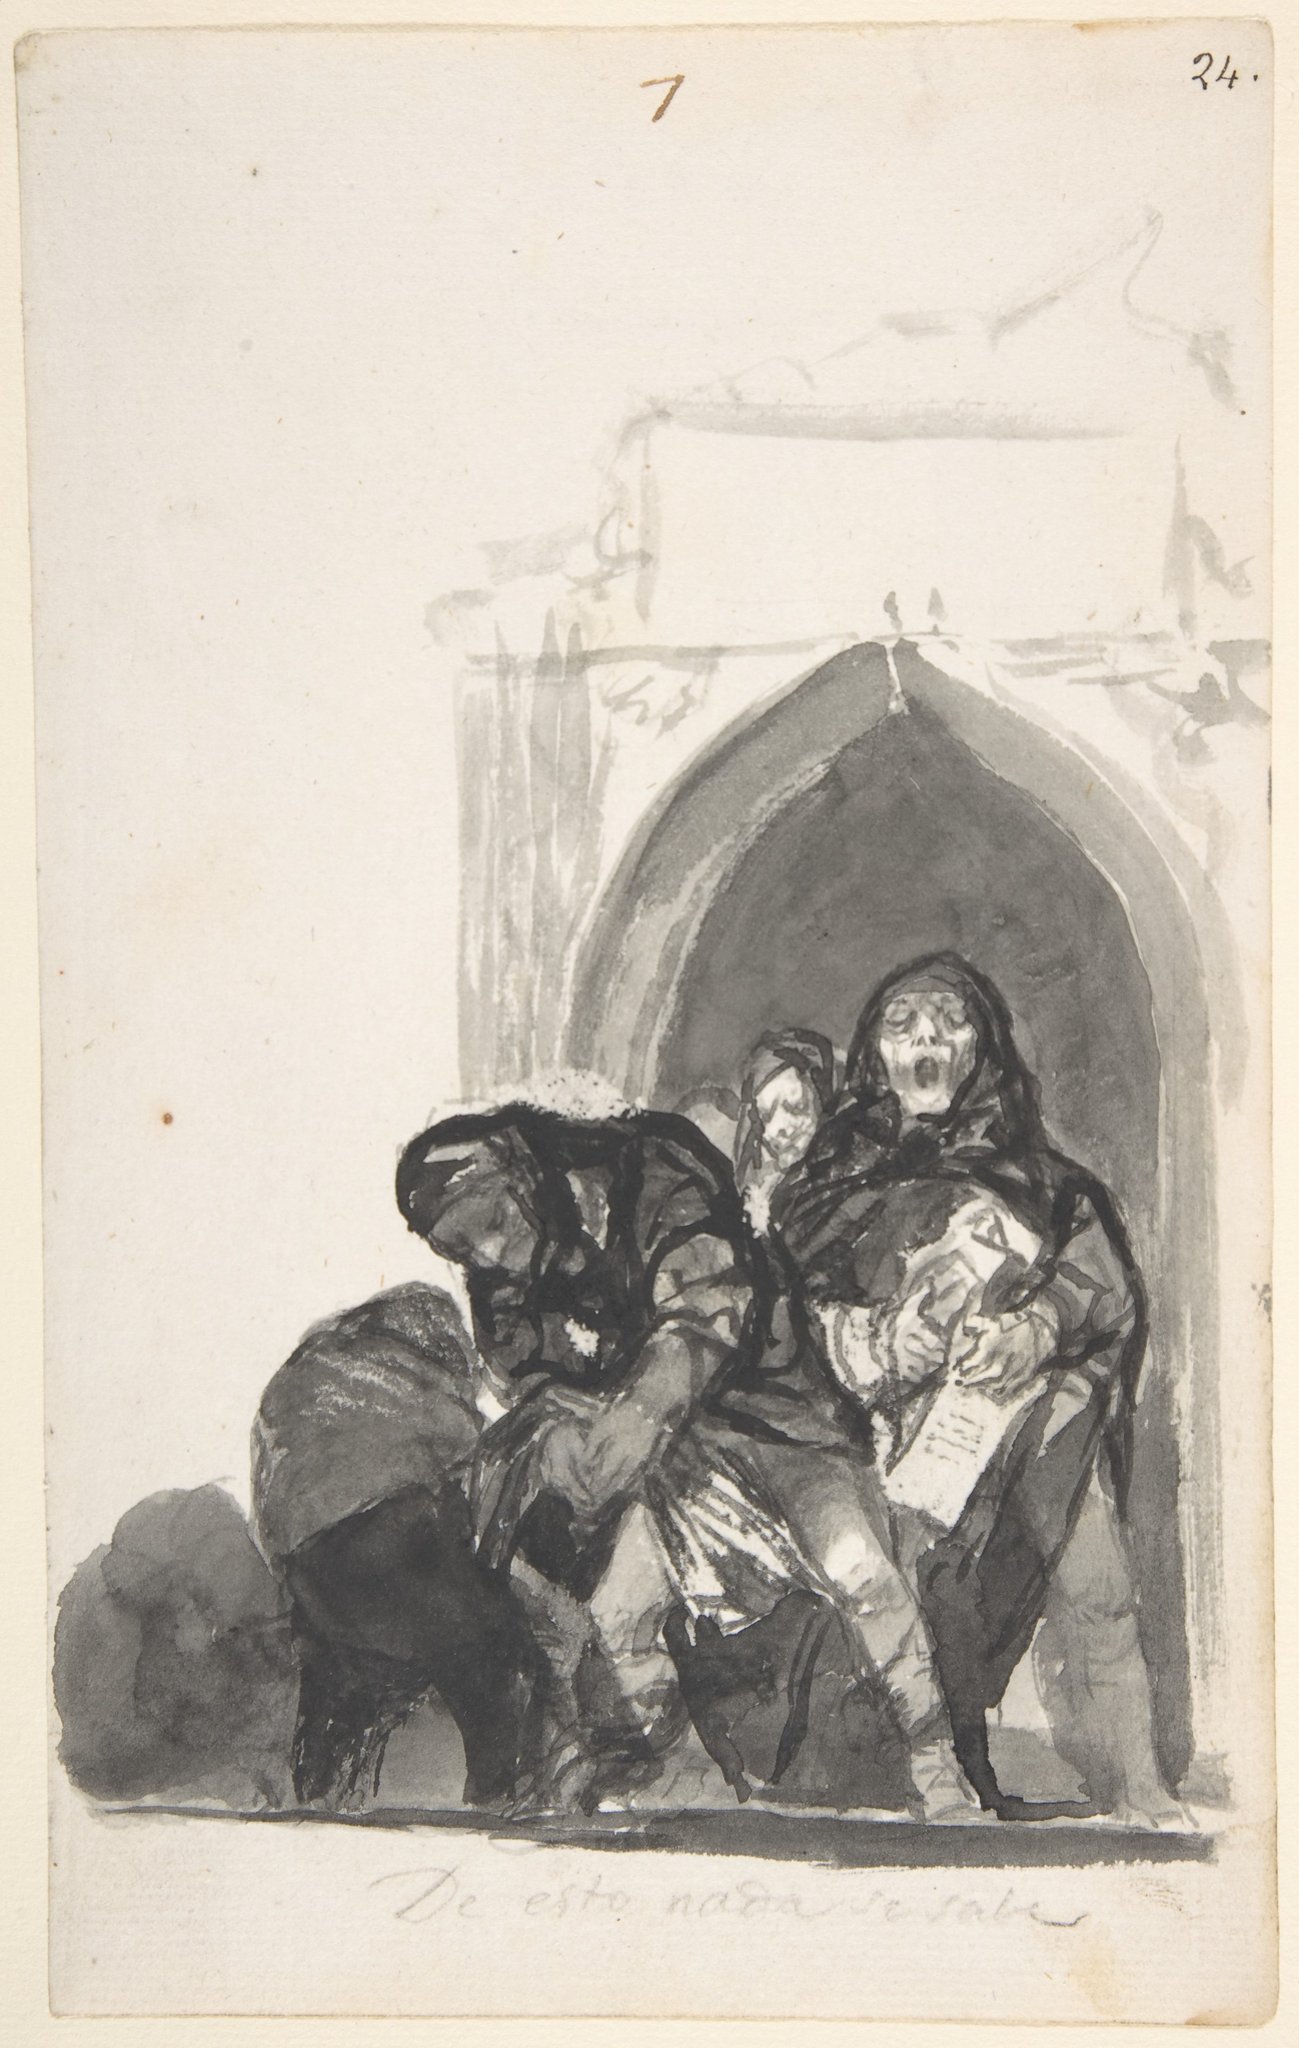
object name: drawing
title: Nothing is Known of This; two figures picking up a body in front of a church, a monk singing next to them and another in the background; page 7 from the "Witches and Old Women" Album (D)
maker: goya (francisco de goya y lucientes)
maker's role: artist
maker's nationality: spanish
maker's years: 1746-1828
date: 1819-1823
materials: ink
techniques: brush, wash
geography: spain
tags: gates,corpses,men,singing,monks